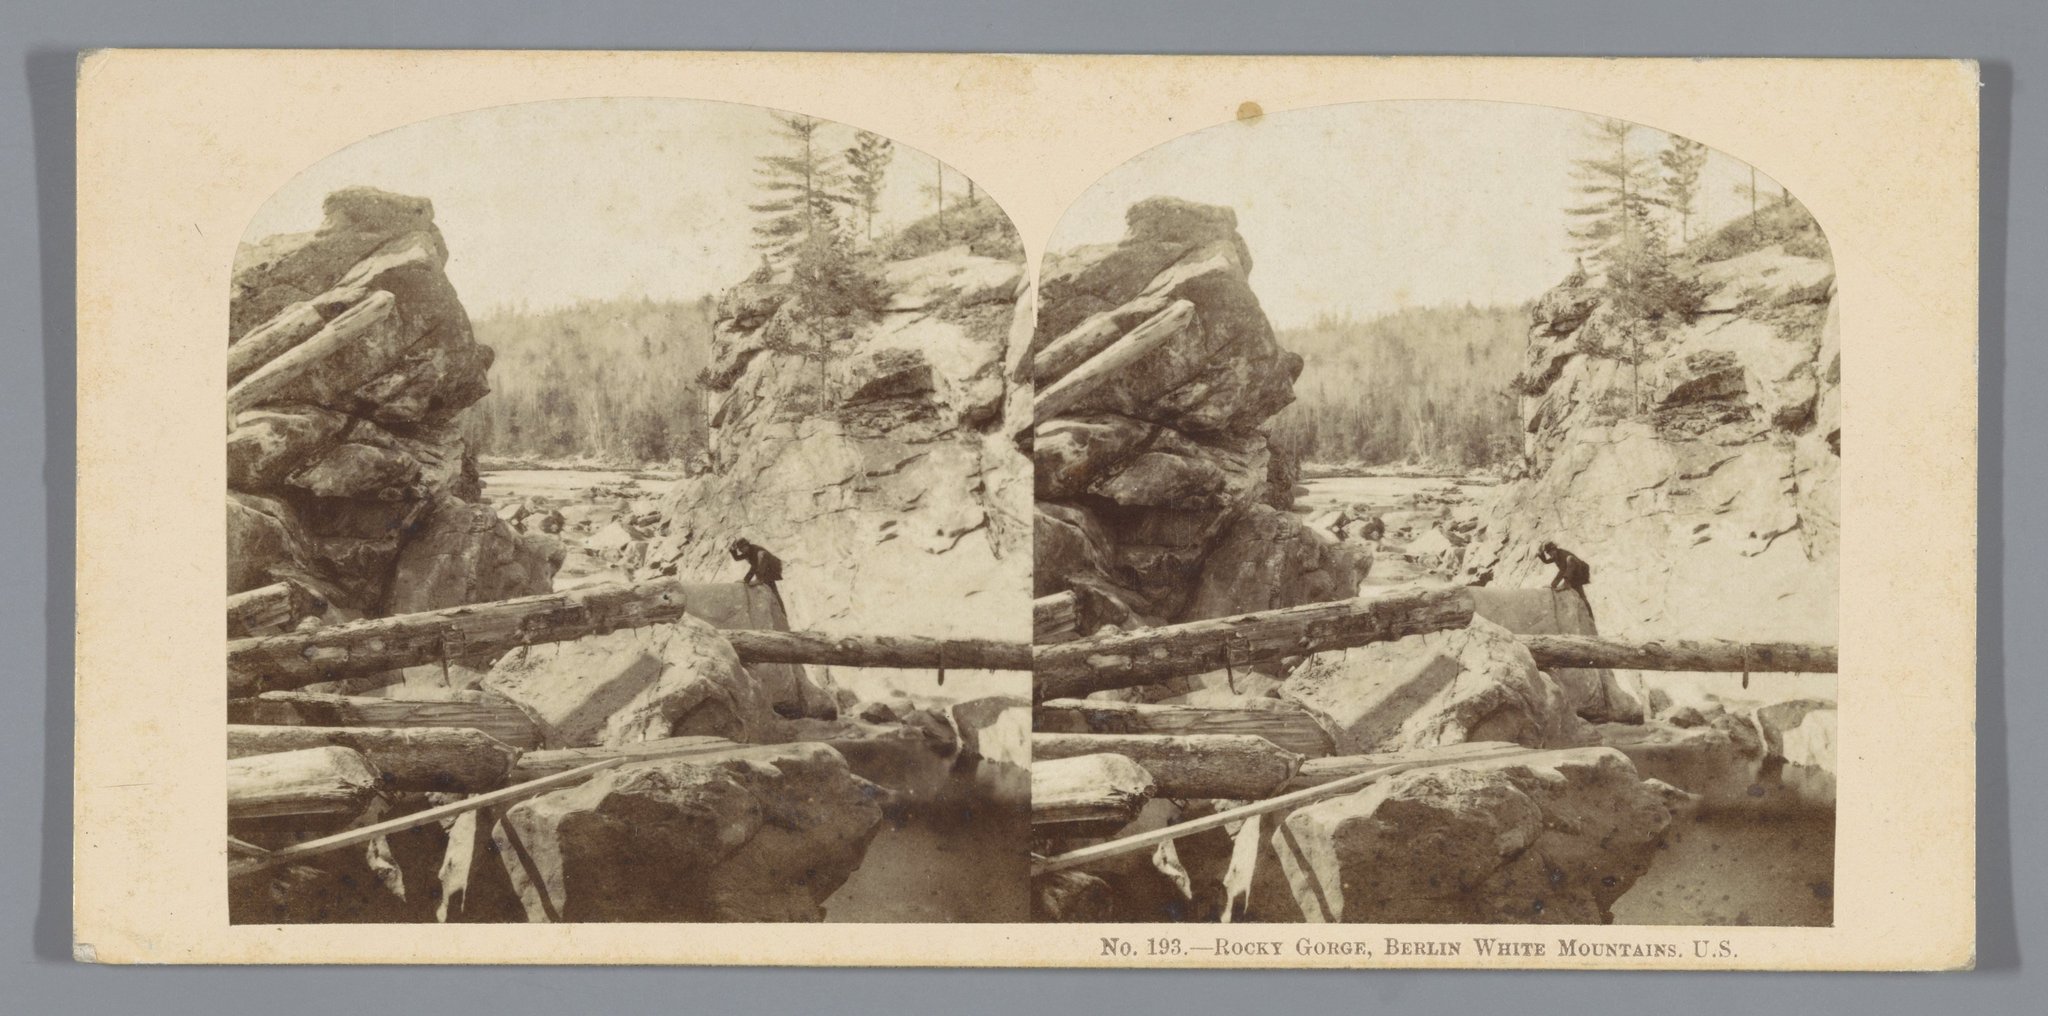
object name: stereograph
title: Man klimt op een rots bij de waterval Rocky Gorge in de White Mountains, New Hampshire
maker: william england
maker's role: fotograaf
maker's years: 1816-1896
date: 1859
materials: cardboard, paper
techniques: albumen print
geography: white mountains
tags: mountain climbing, mountaineering, rock-formations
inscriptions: number: ‘No. 193’, : ‘"I've traversed many (...) to roam." - Scott.’